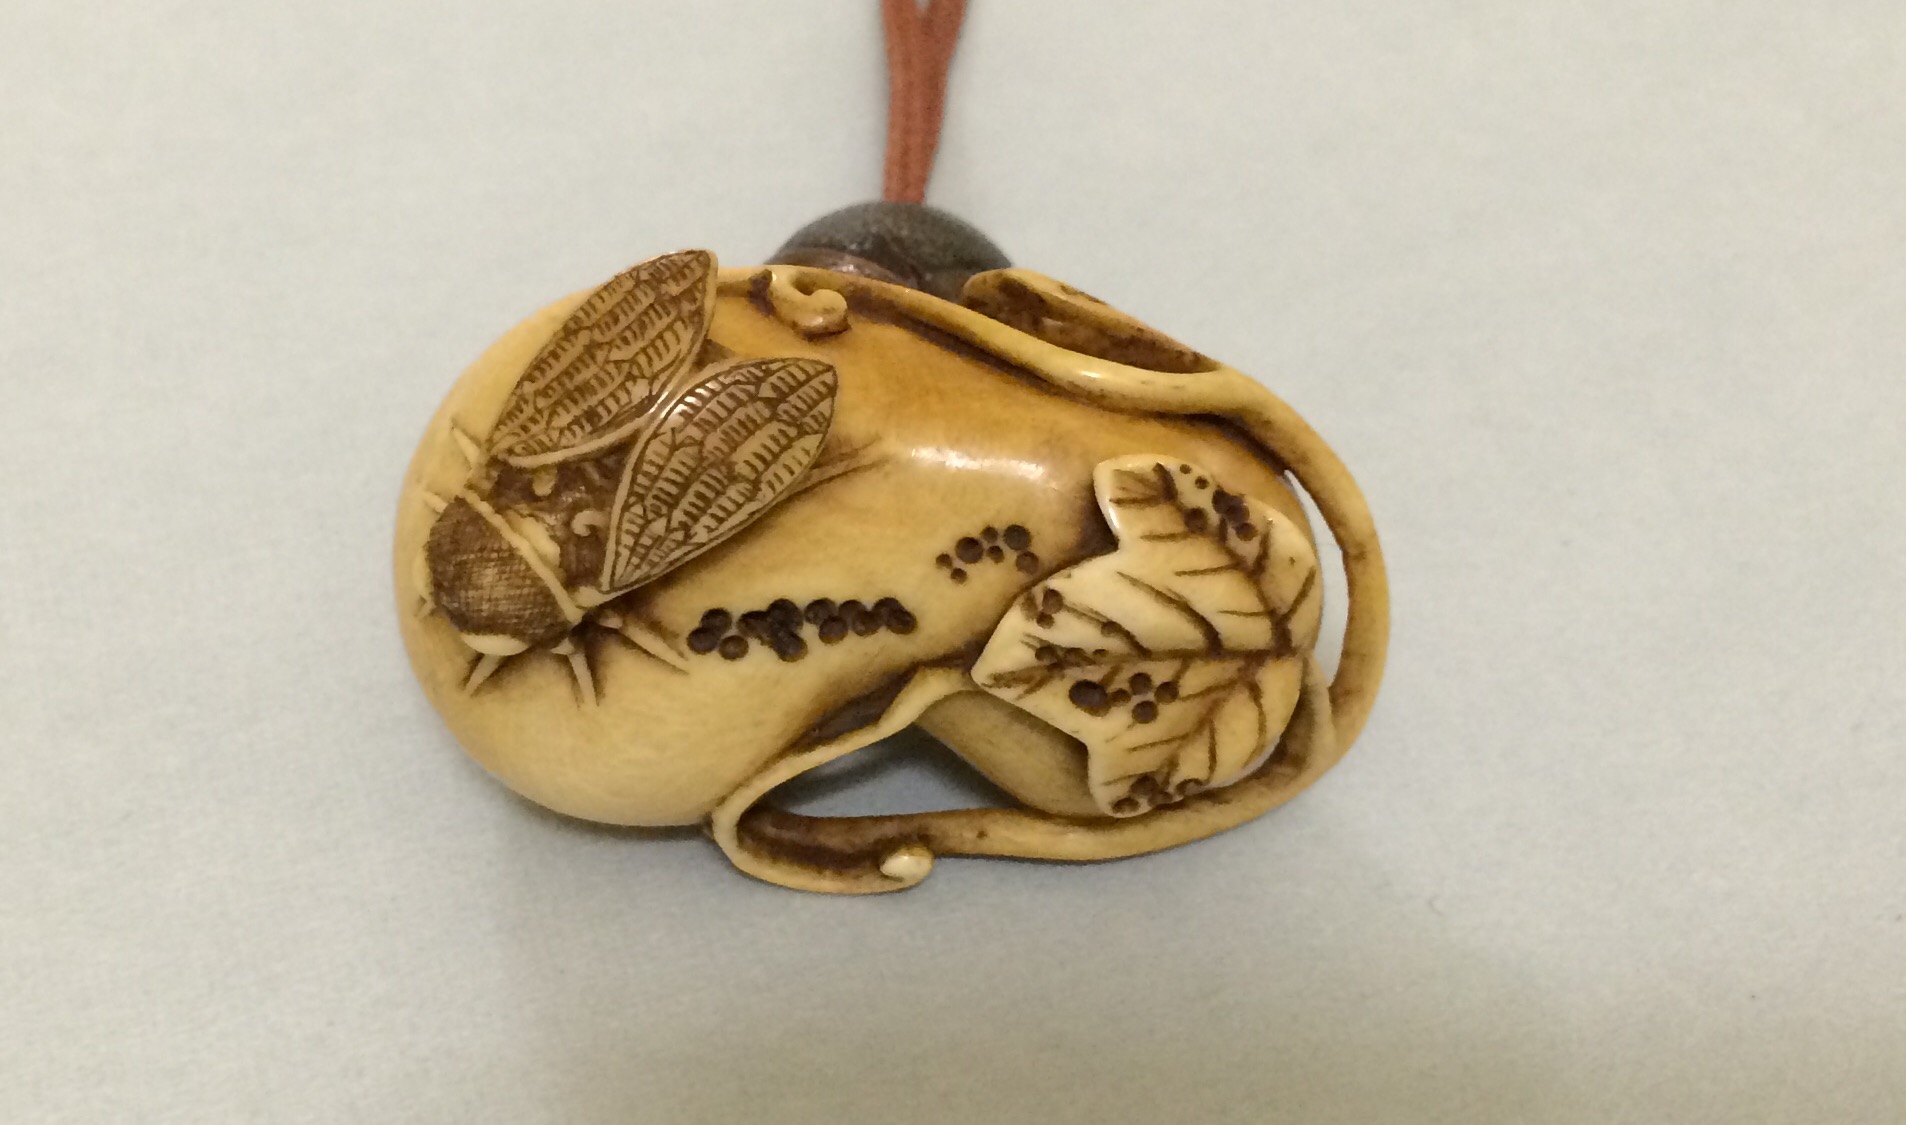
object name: netsuke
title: Gourd and Cicada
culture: japanese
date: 1801-1900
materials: ivory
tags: insects